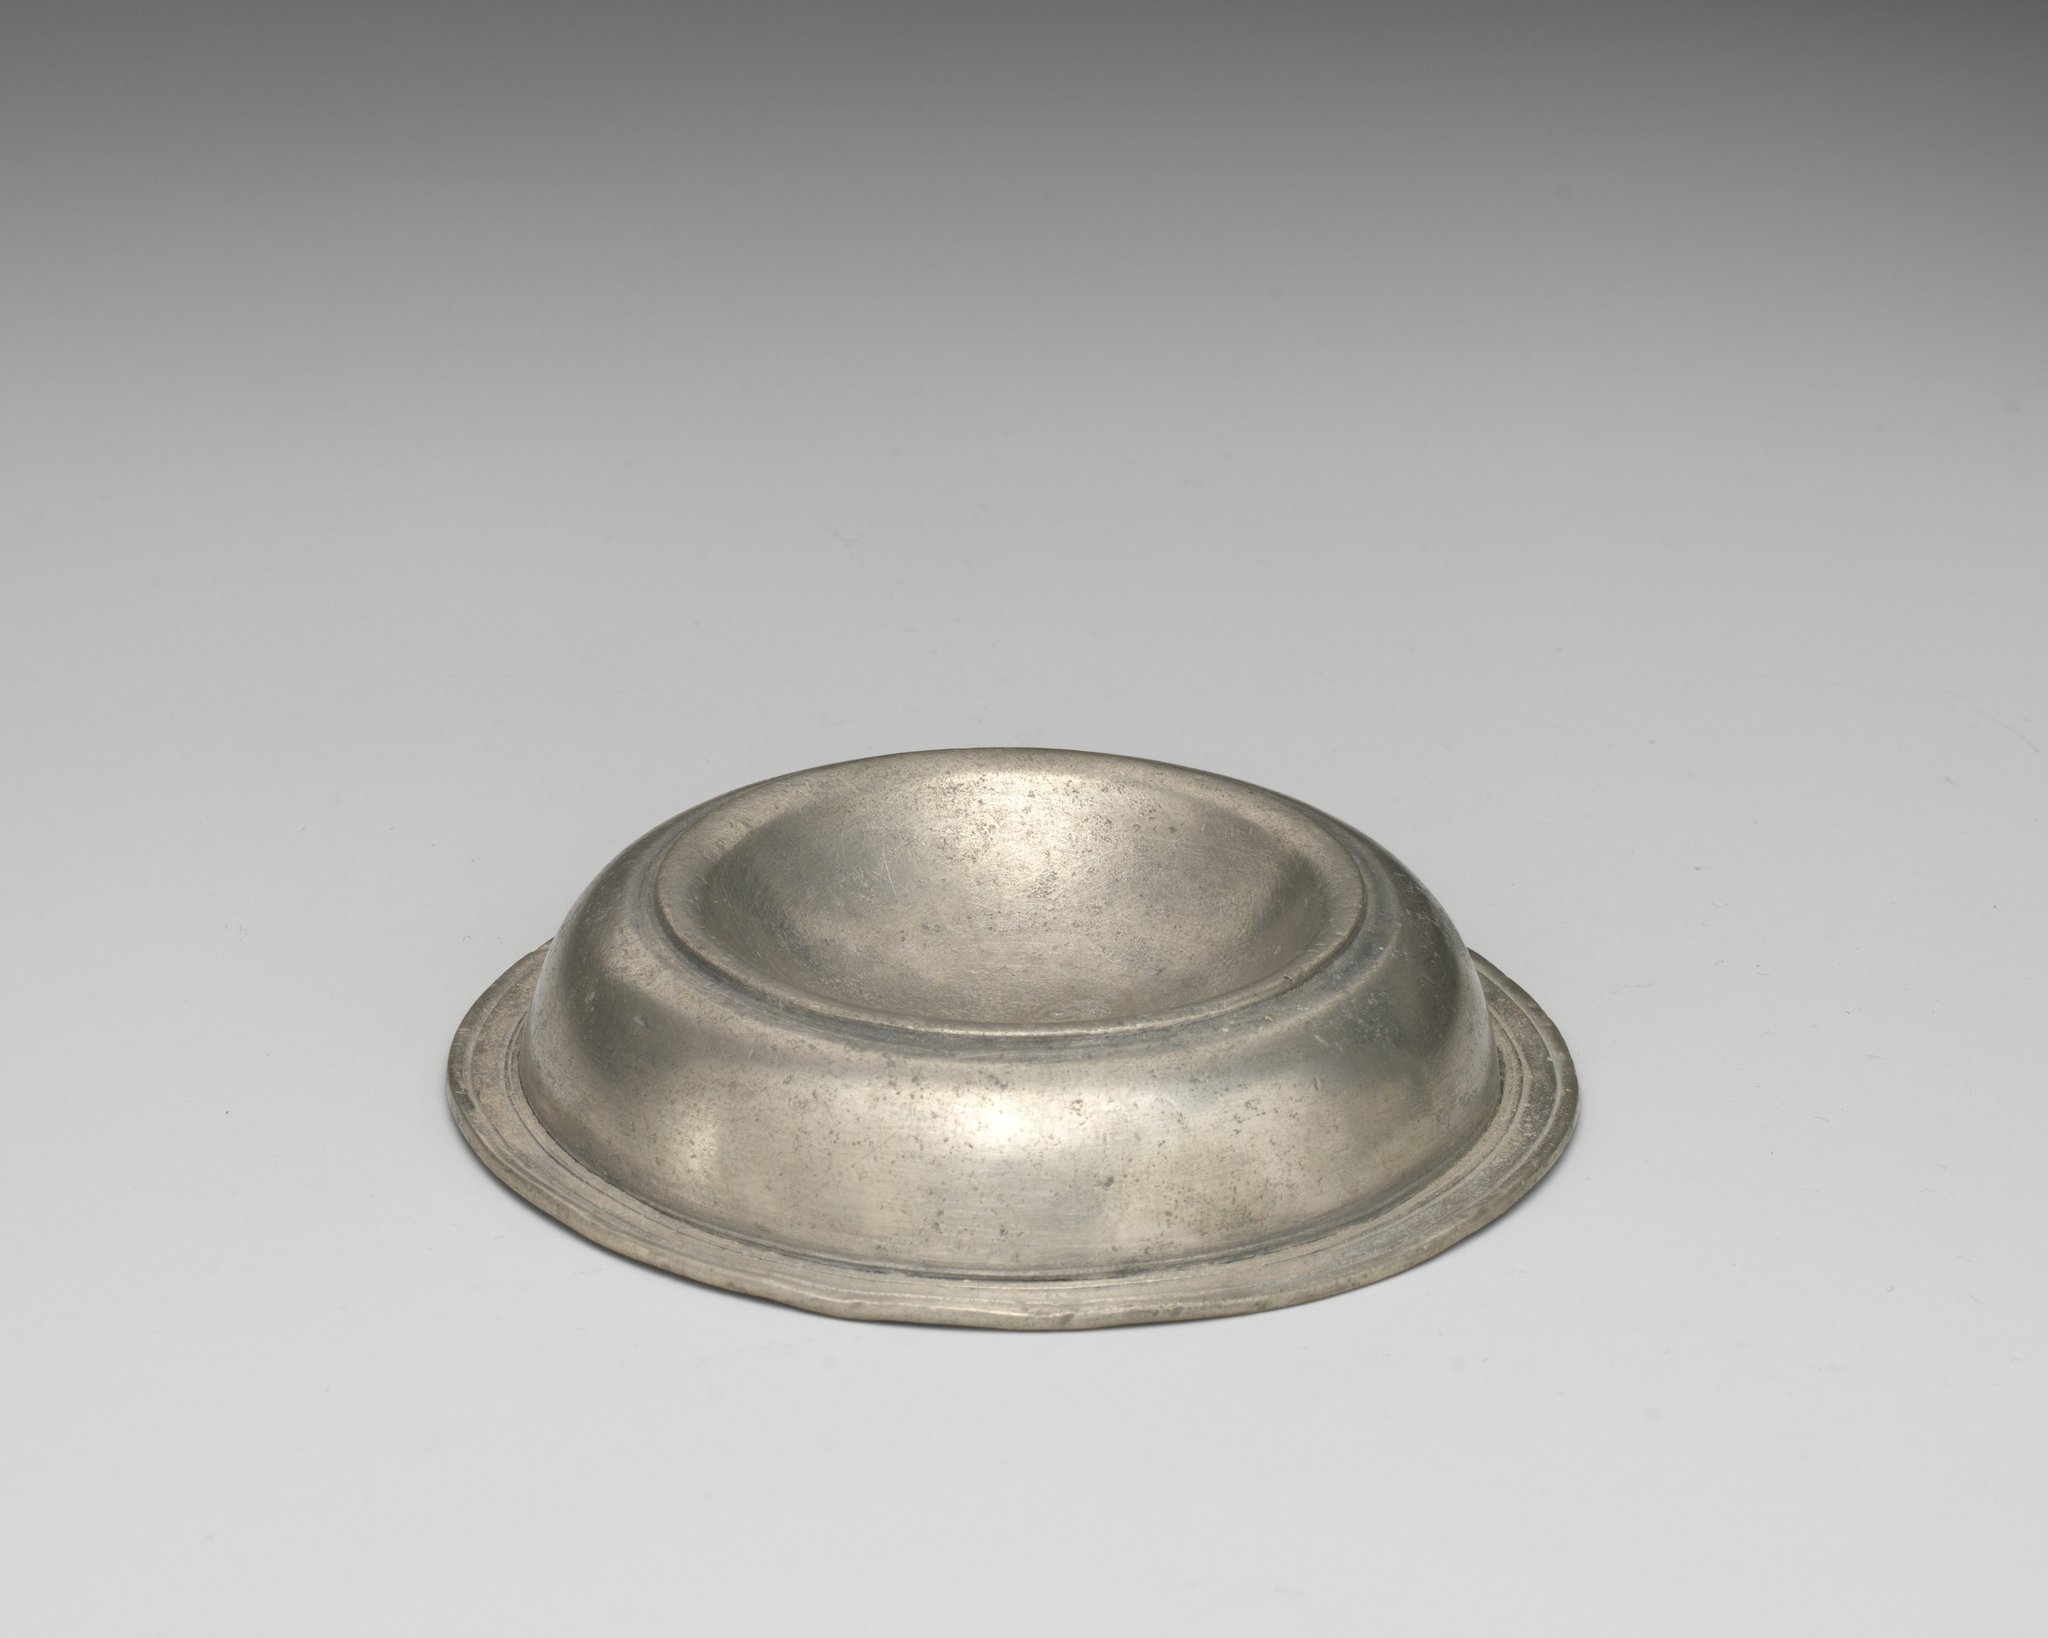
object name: salt trencher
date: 1701-1733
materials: pewter